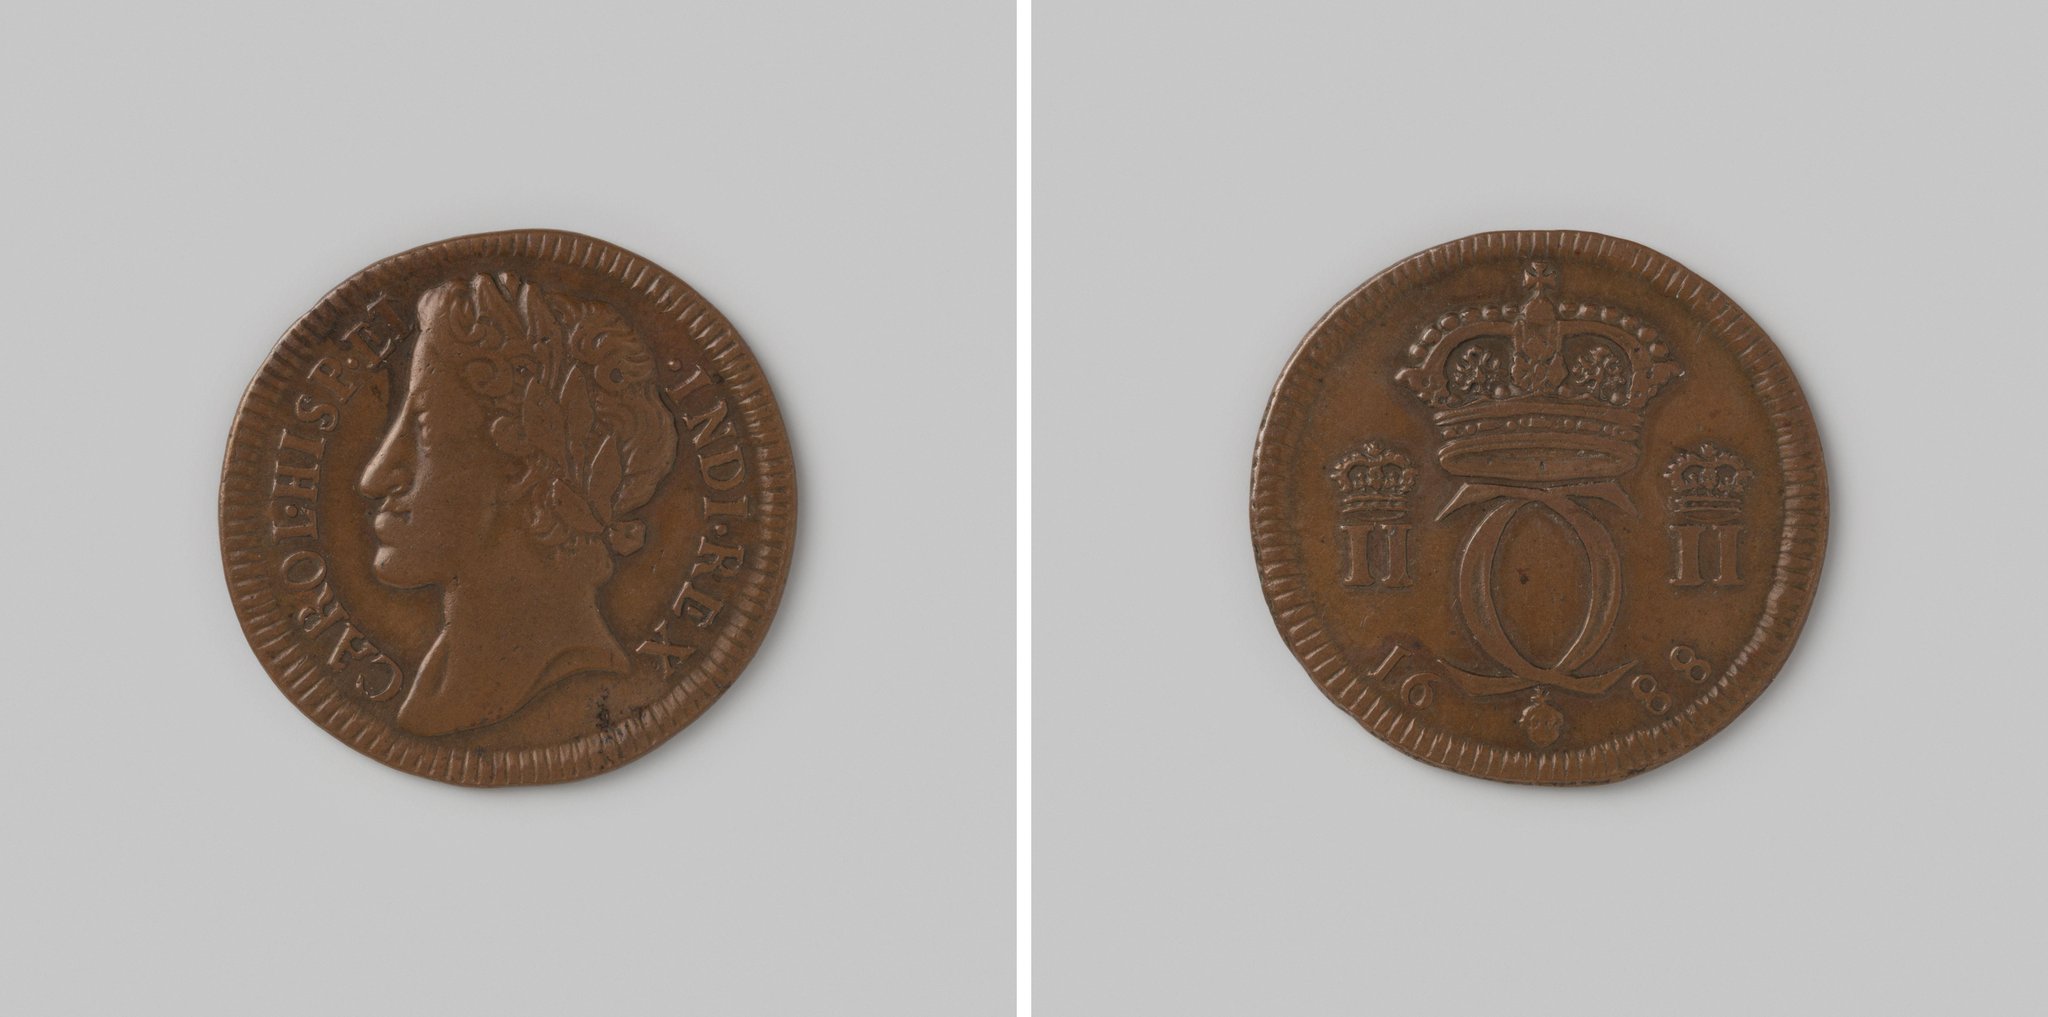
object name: jeton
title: Rekenpenning uit Brussel op Koning Karel II 1688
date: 1688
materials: copper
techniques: striking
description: Koperen penning, op de voorzijde het portret van Karel II naar lins met omschrift, op de keerzijde een gekroond spiegelmonogram C tussen twee gekroonde cijfers II, waaronder het jaartal.